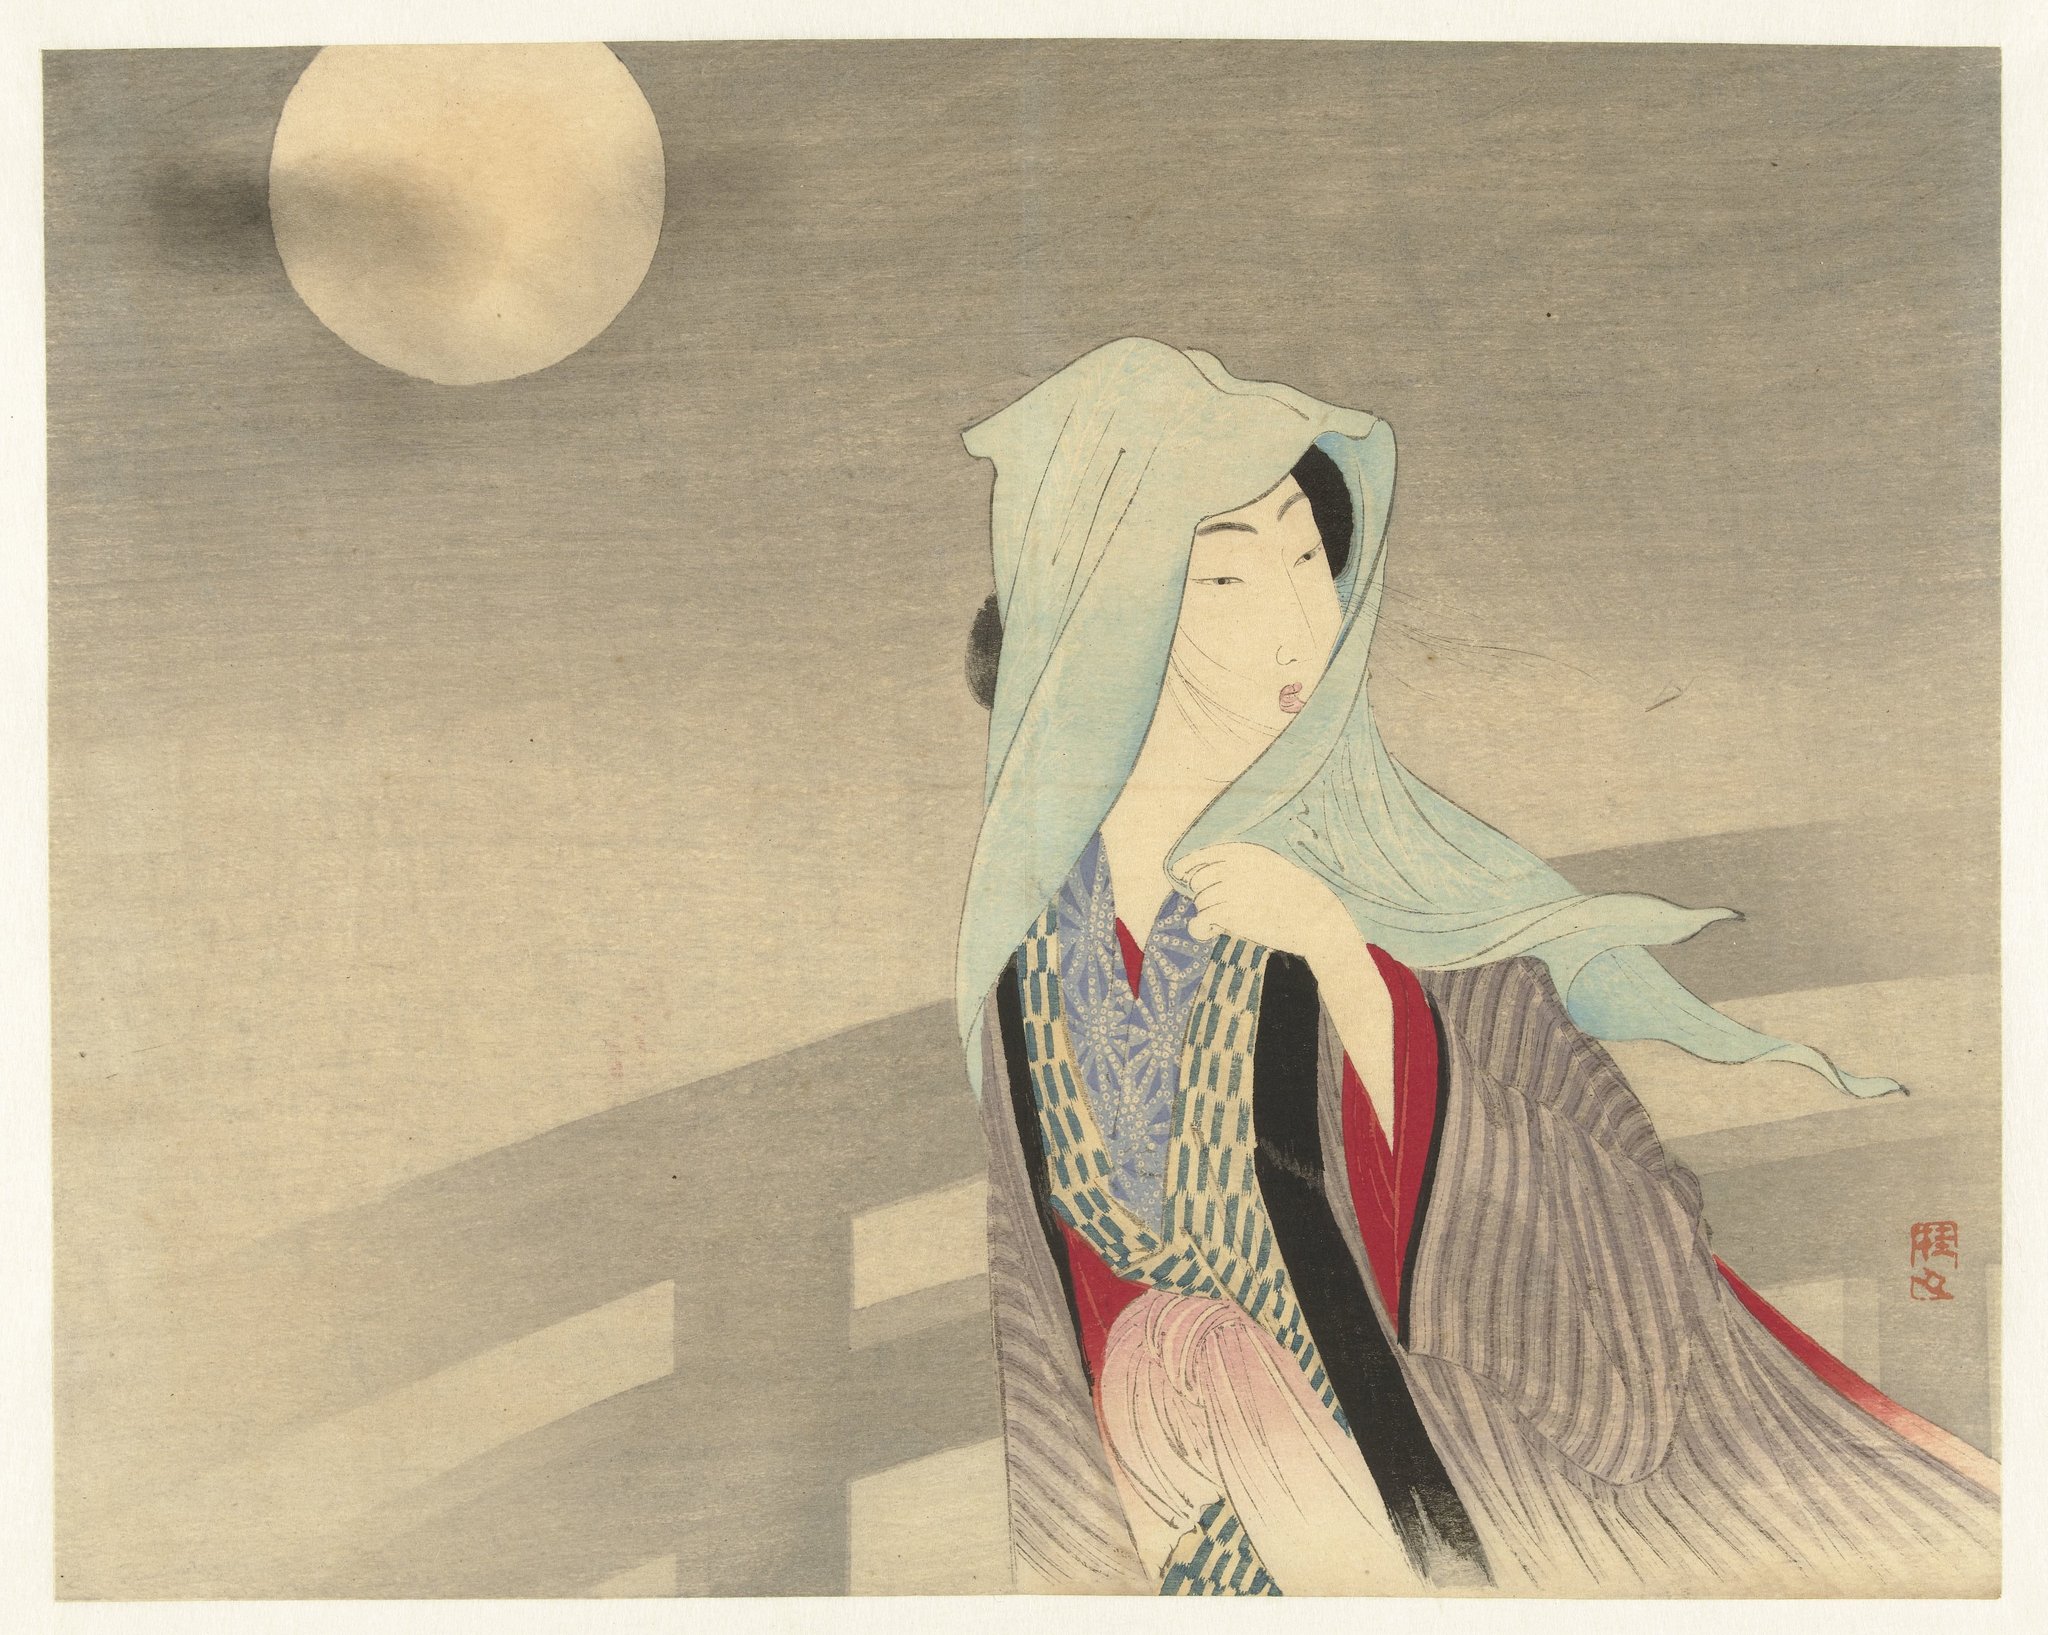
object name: kuchi e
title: Gesluierde vrouw op een brug bij maanlicht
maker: takeuchi keishu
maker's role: print maker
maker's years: 1861-1942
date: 1900-1925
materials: paper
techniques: woodcut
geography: tokyo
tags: full moon, adult woman, veil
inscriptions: collector's mark: Lugt 2760, collector's mark: Lugt 2228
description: Gesluierde vrouw in kimono op een houten brug bij helder maanlicht.